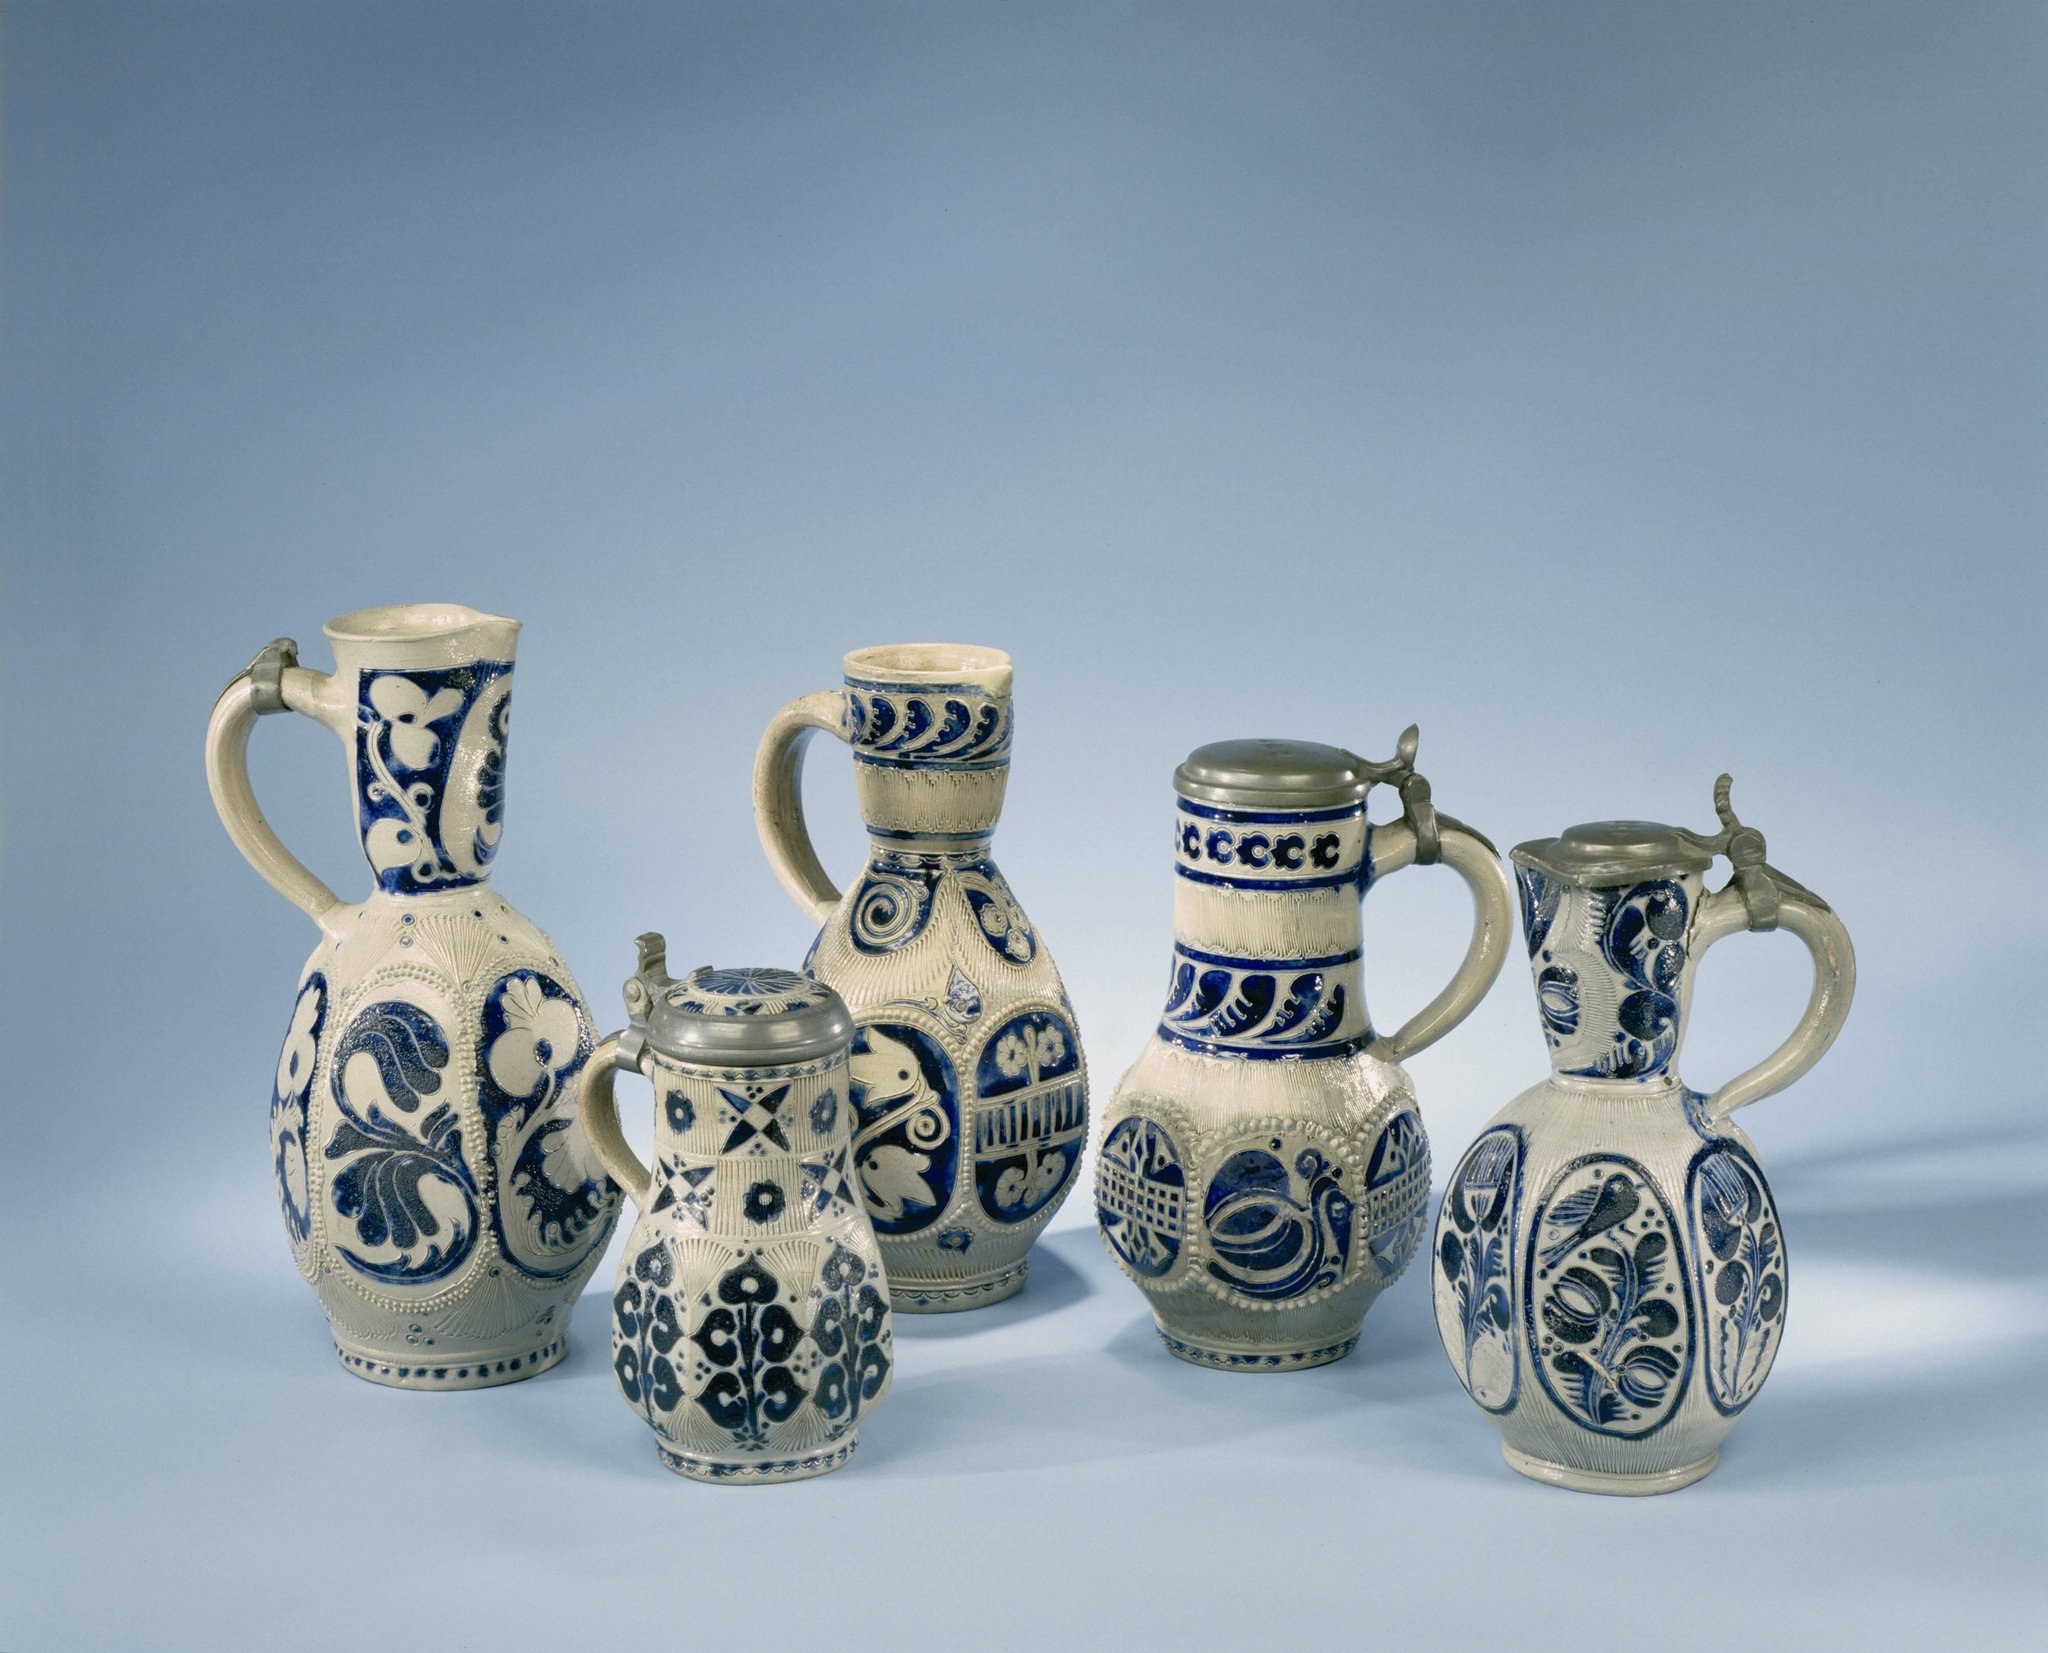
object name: ewer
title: Jug with bird and stylized flowers in medallions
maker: Anonymous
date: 1750-1799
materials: cobalt, glaze, stoneware, tin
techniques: firing, forming, turning, vitrification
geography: westerwald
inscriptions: inscription: ‘AVH’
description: Kan van steengoed op standring met een zeshoekige, eivormige buik en smalle nek met een geknepen tuit. Het C-vormige oor is bevestigd aan de nek en de schouder. Gedeeltelijk bedekt met kobaltblauw. Op de buik zesmaal een ingegrifte en ingekleurde decoratie van een ovale medaillon met een vogel op een gestileerde bloem of alleen een bloem. Om de vakken een ingedrukte zigzaglijn (knibis). Op de nek een gestileerde bloem in een gelobd medaillon gevormd door een zigzaglijn en aan weerszijden omvat door een bladrank. Aan het oor is bevestigd een tinnen montuur met een deksel. Gegraveerd in de deksel de letters 'A V H'. Westerwald.